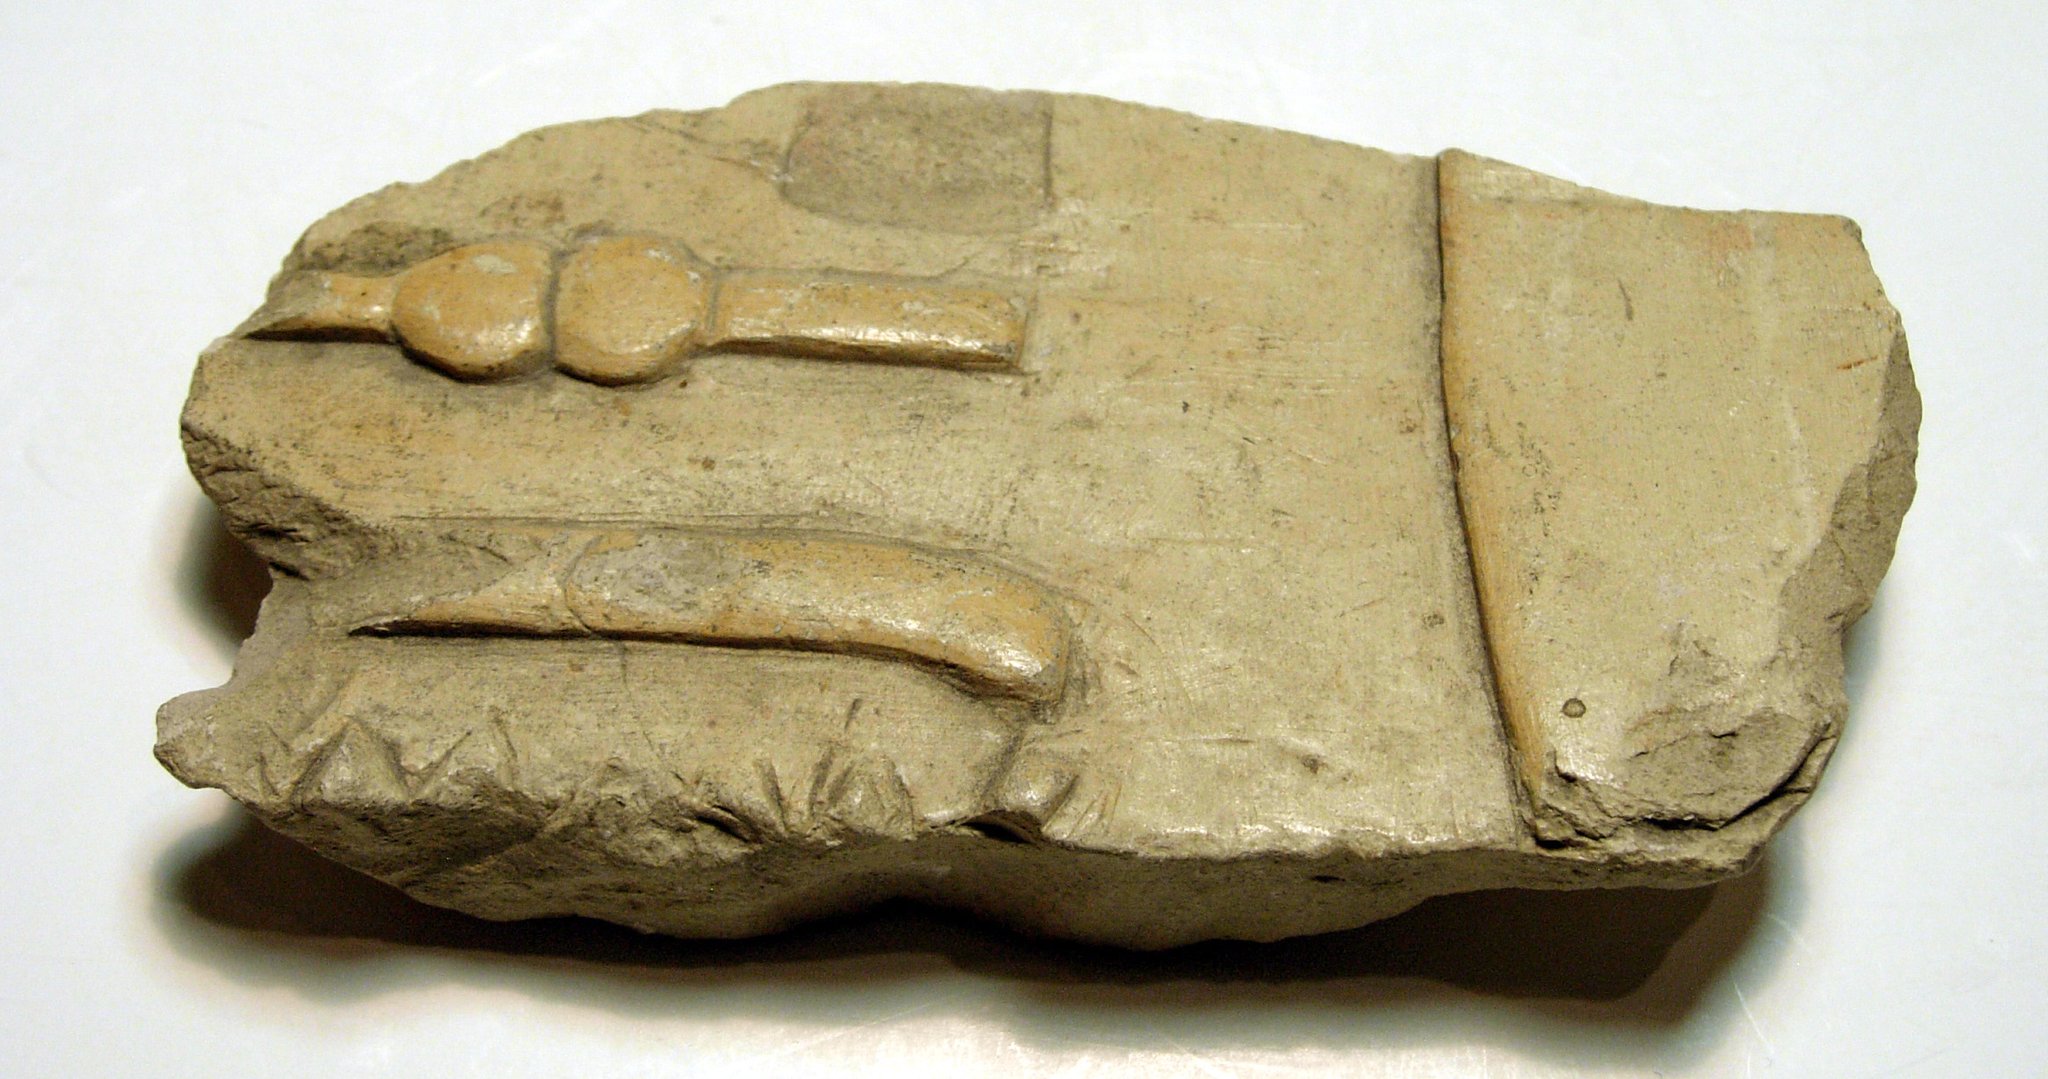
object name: relief, tomb of nespekashuty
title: Raised relief fragment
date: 664-610 BCE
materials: limestone, varnish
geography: egypt